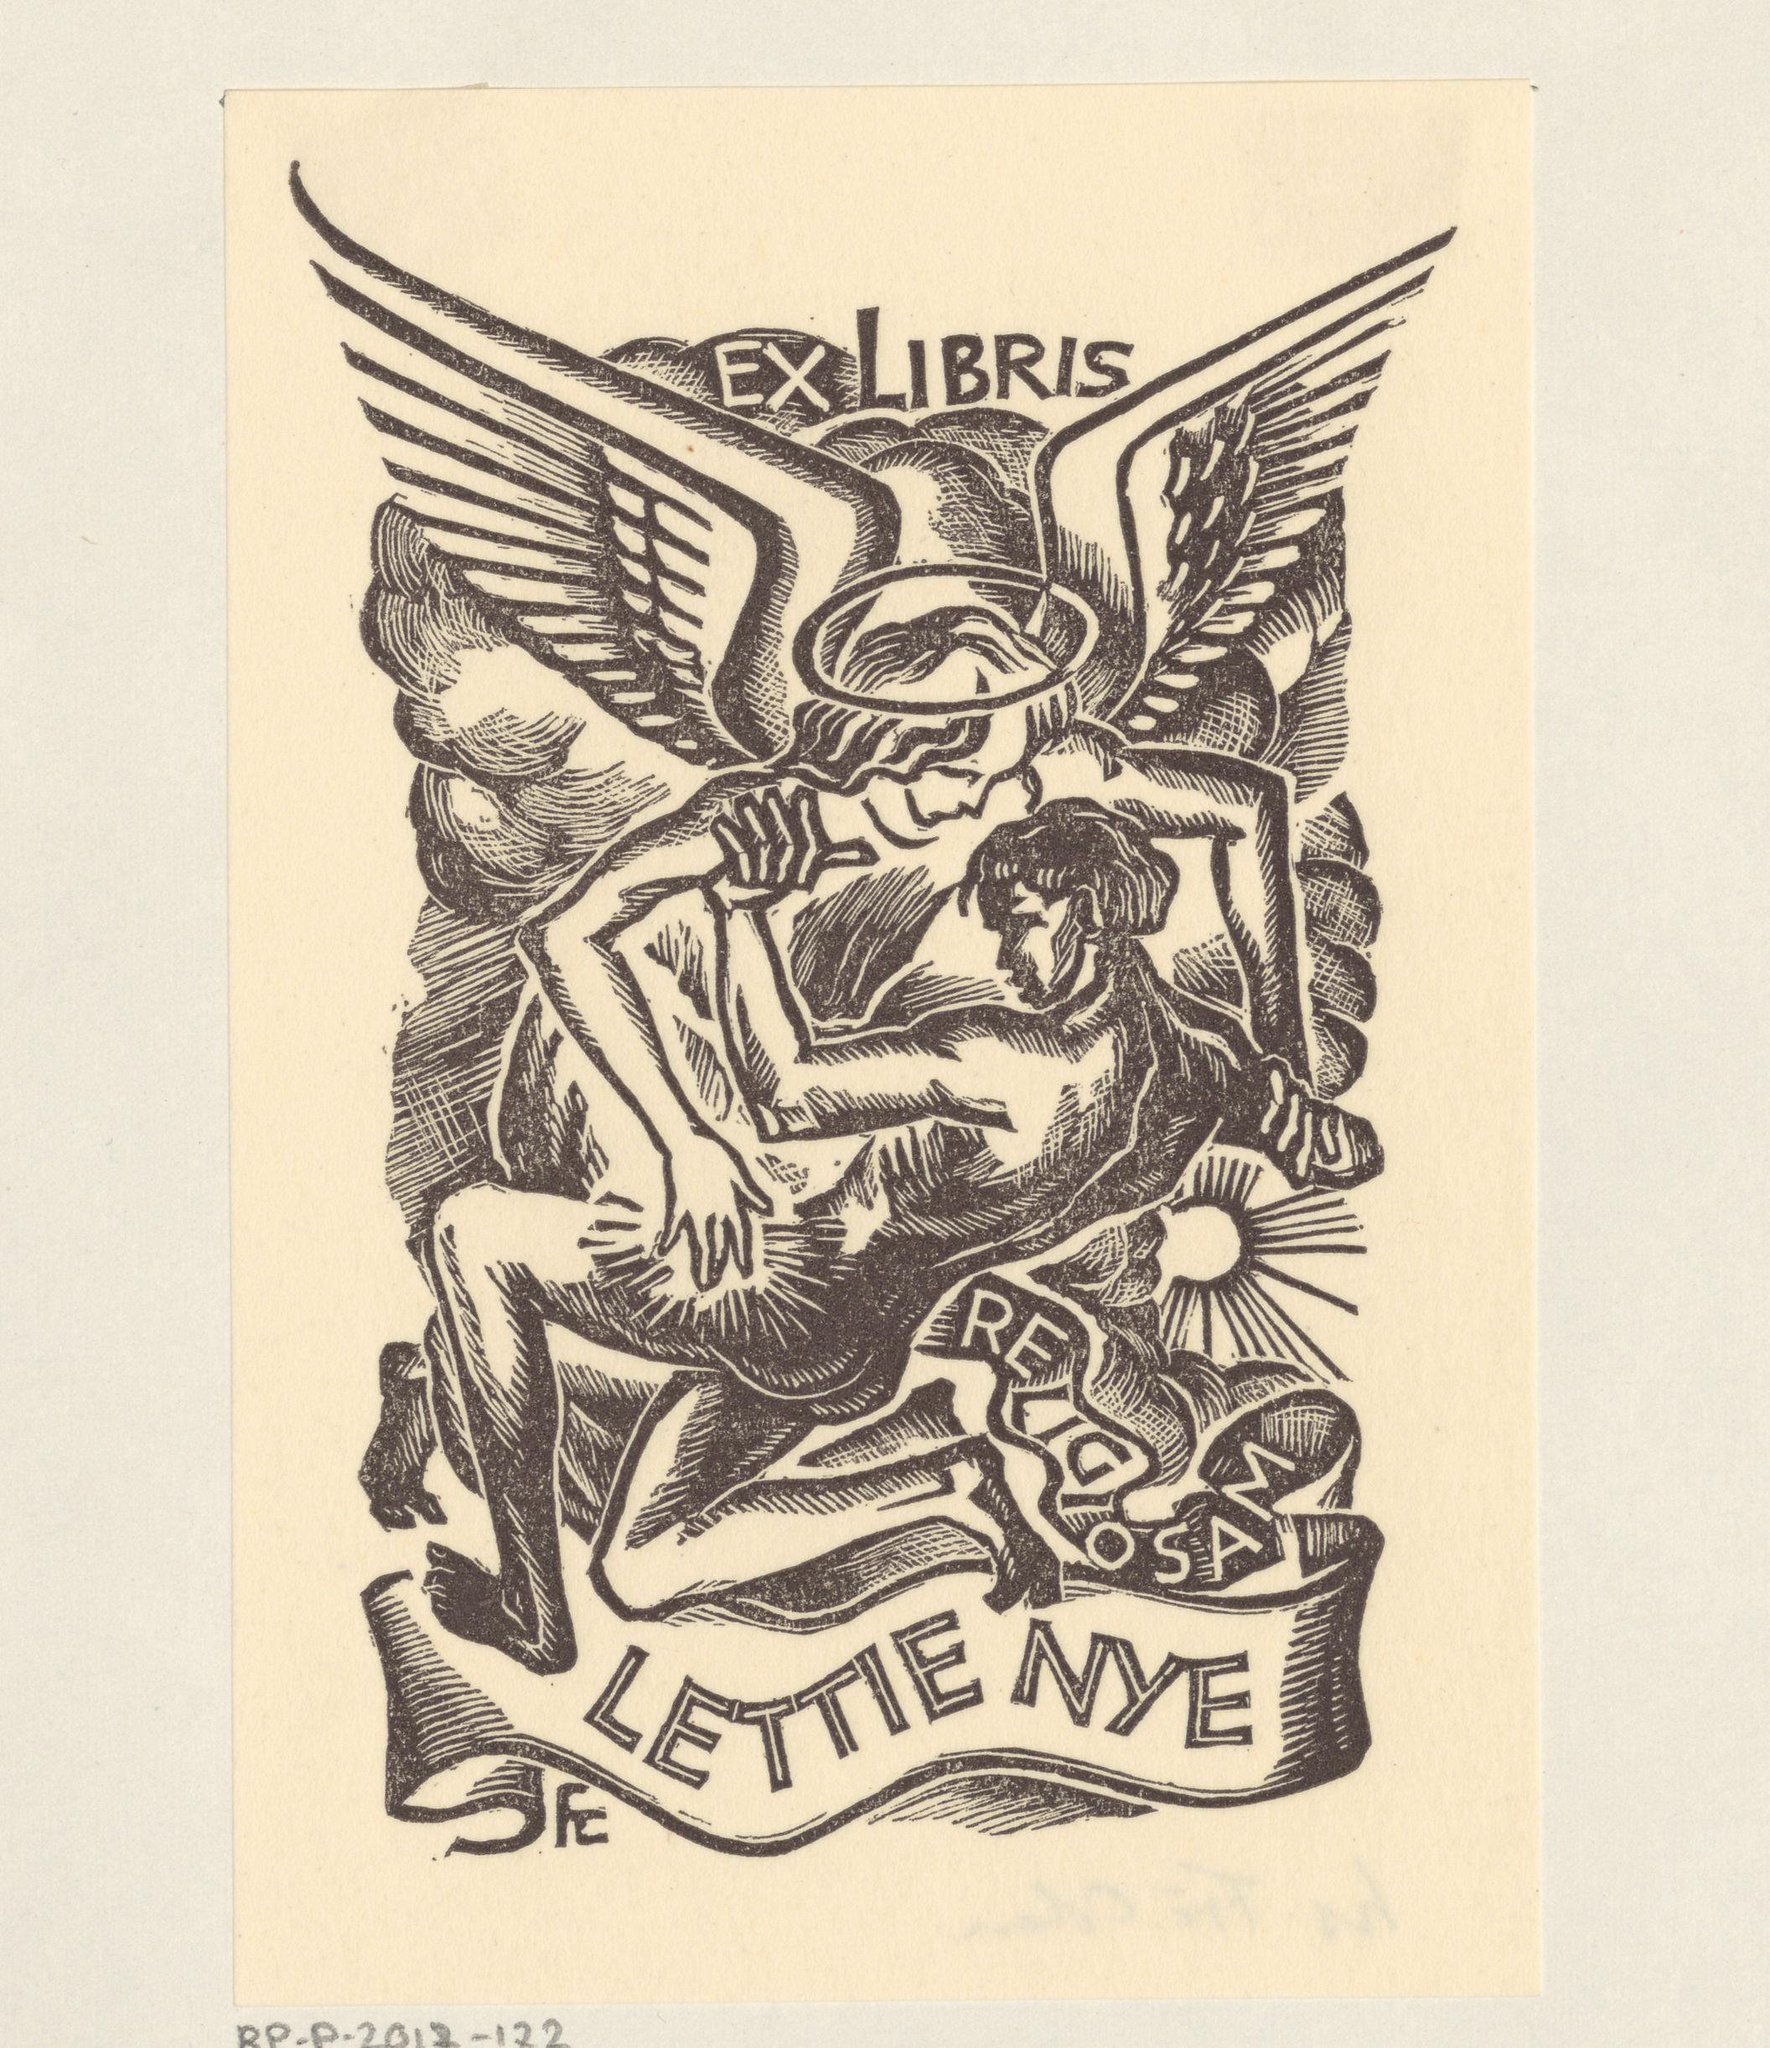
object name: bookplate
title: Ex libris van Letti Nye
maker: fré cohen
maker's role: draughtsman, print maker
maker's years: 1903-1943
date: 1941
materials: paper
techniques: woodcut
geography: netherlands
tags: jacob wrestles with the angel (or man) till daybreak; jacob's thigh is put out of joint, christian religion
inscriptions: inscription: ‘hs Fré Cohen’